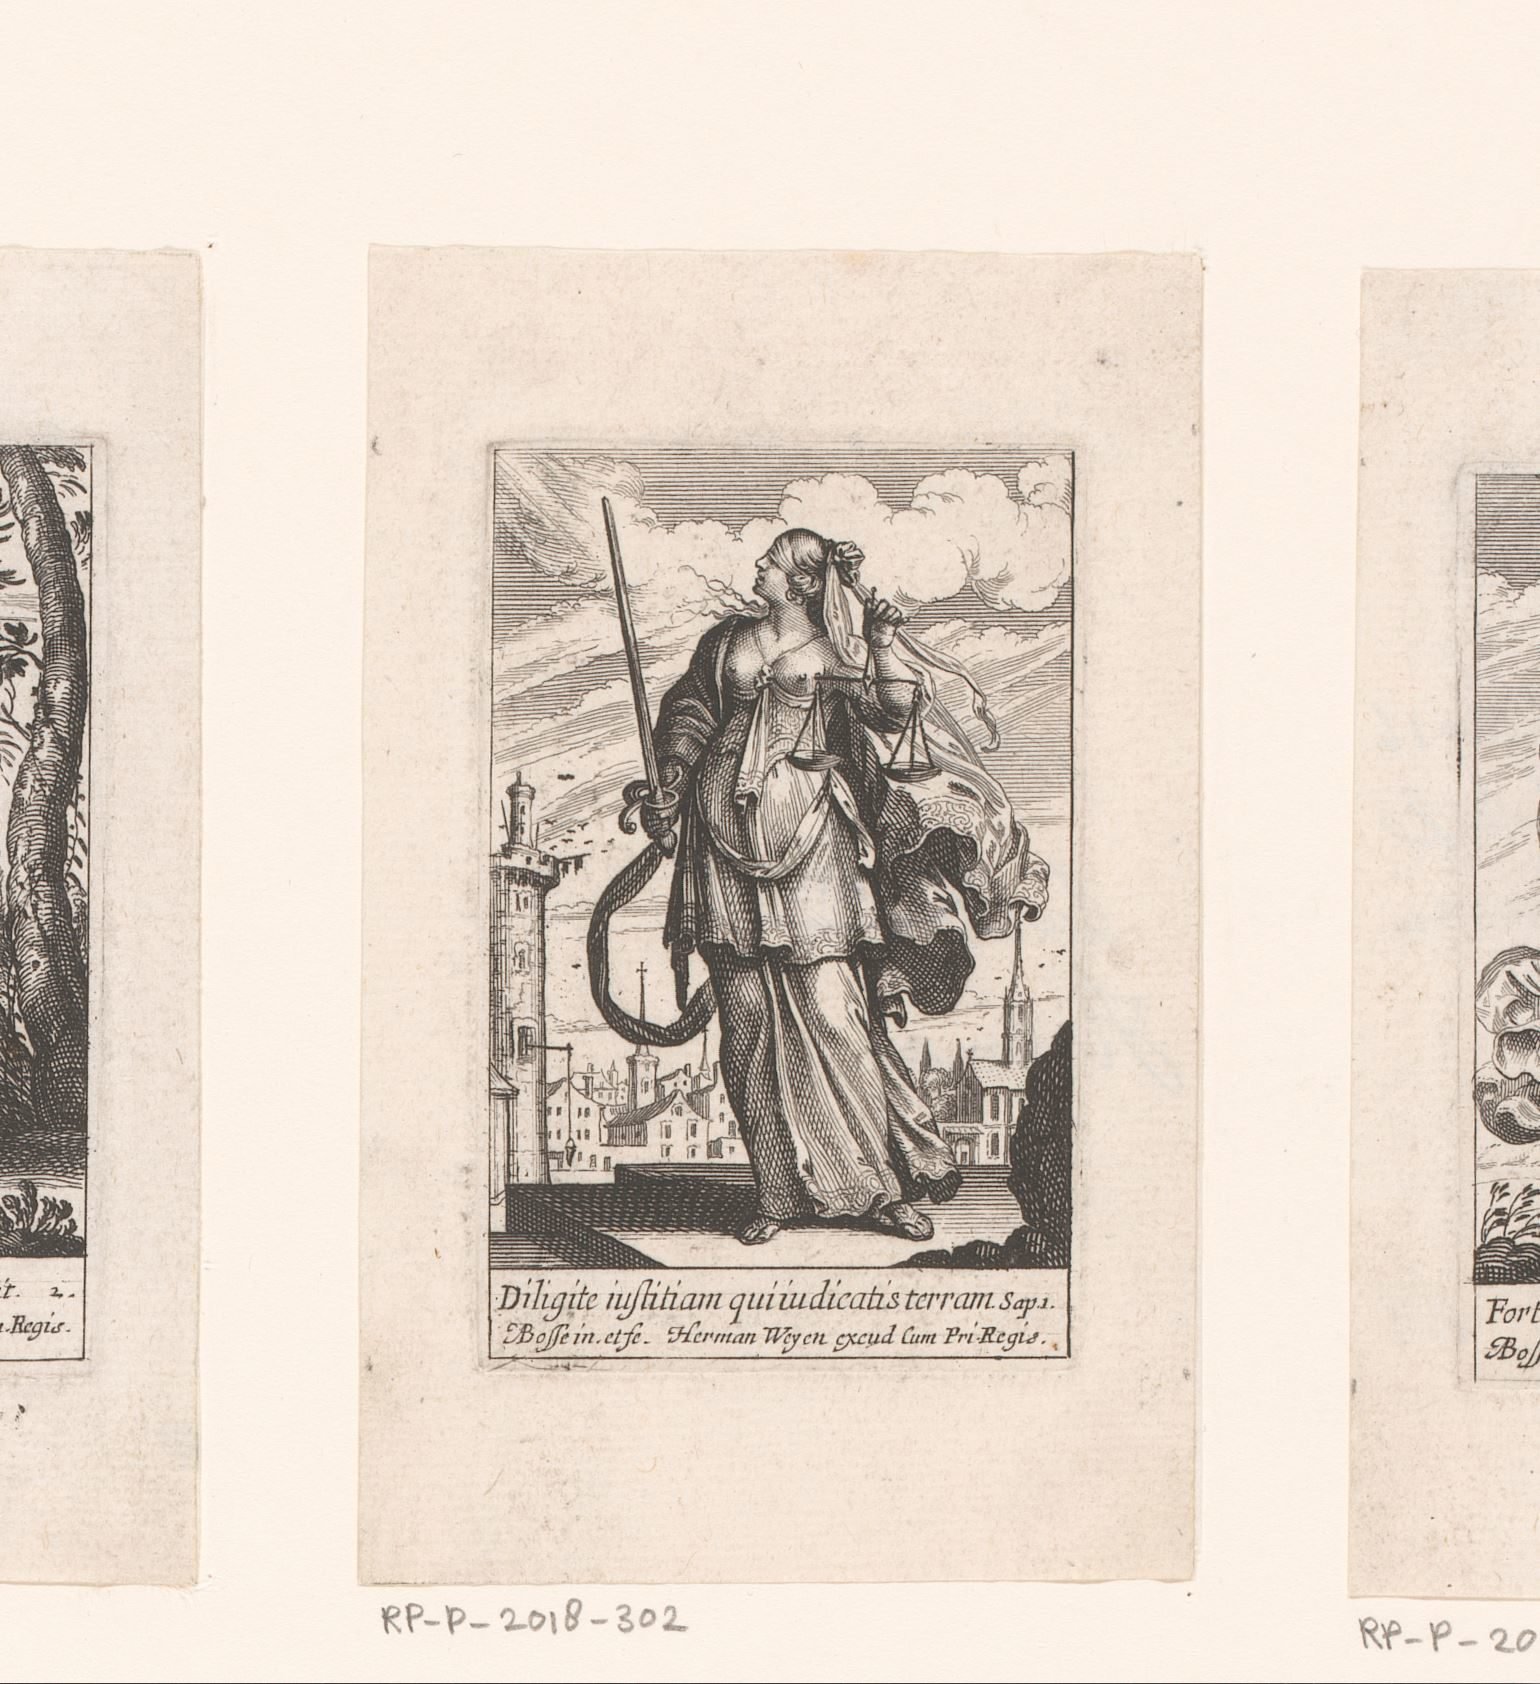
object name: print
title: Gerechtigheid (Justitia)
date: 1636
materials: paper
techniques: engraving, etching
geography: paris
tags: justice, 'justitia'; 'giustitia divina' (ripa) ~ one of the four cardinal virtues, the seven virtues (symbolized)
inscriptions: inscription: ‘1886 Jan 16/ dubbel/ Holman’, collector's mark: Lugt 2228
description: Maakt deel uit van een serie van negen prenten (inclusief twee titelprenten) met personificaties van de zeven deugden.